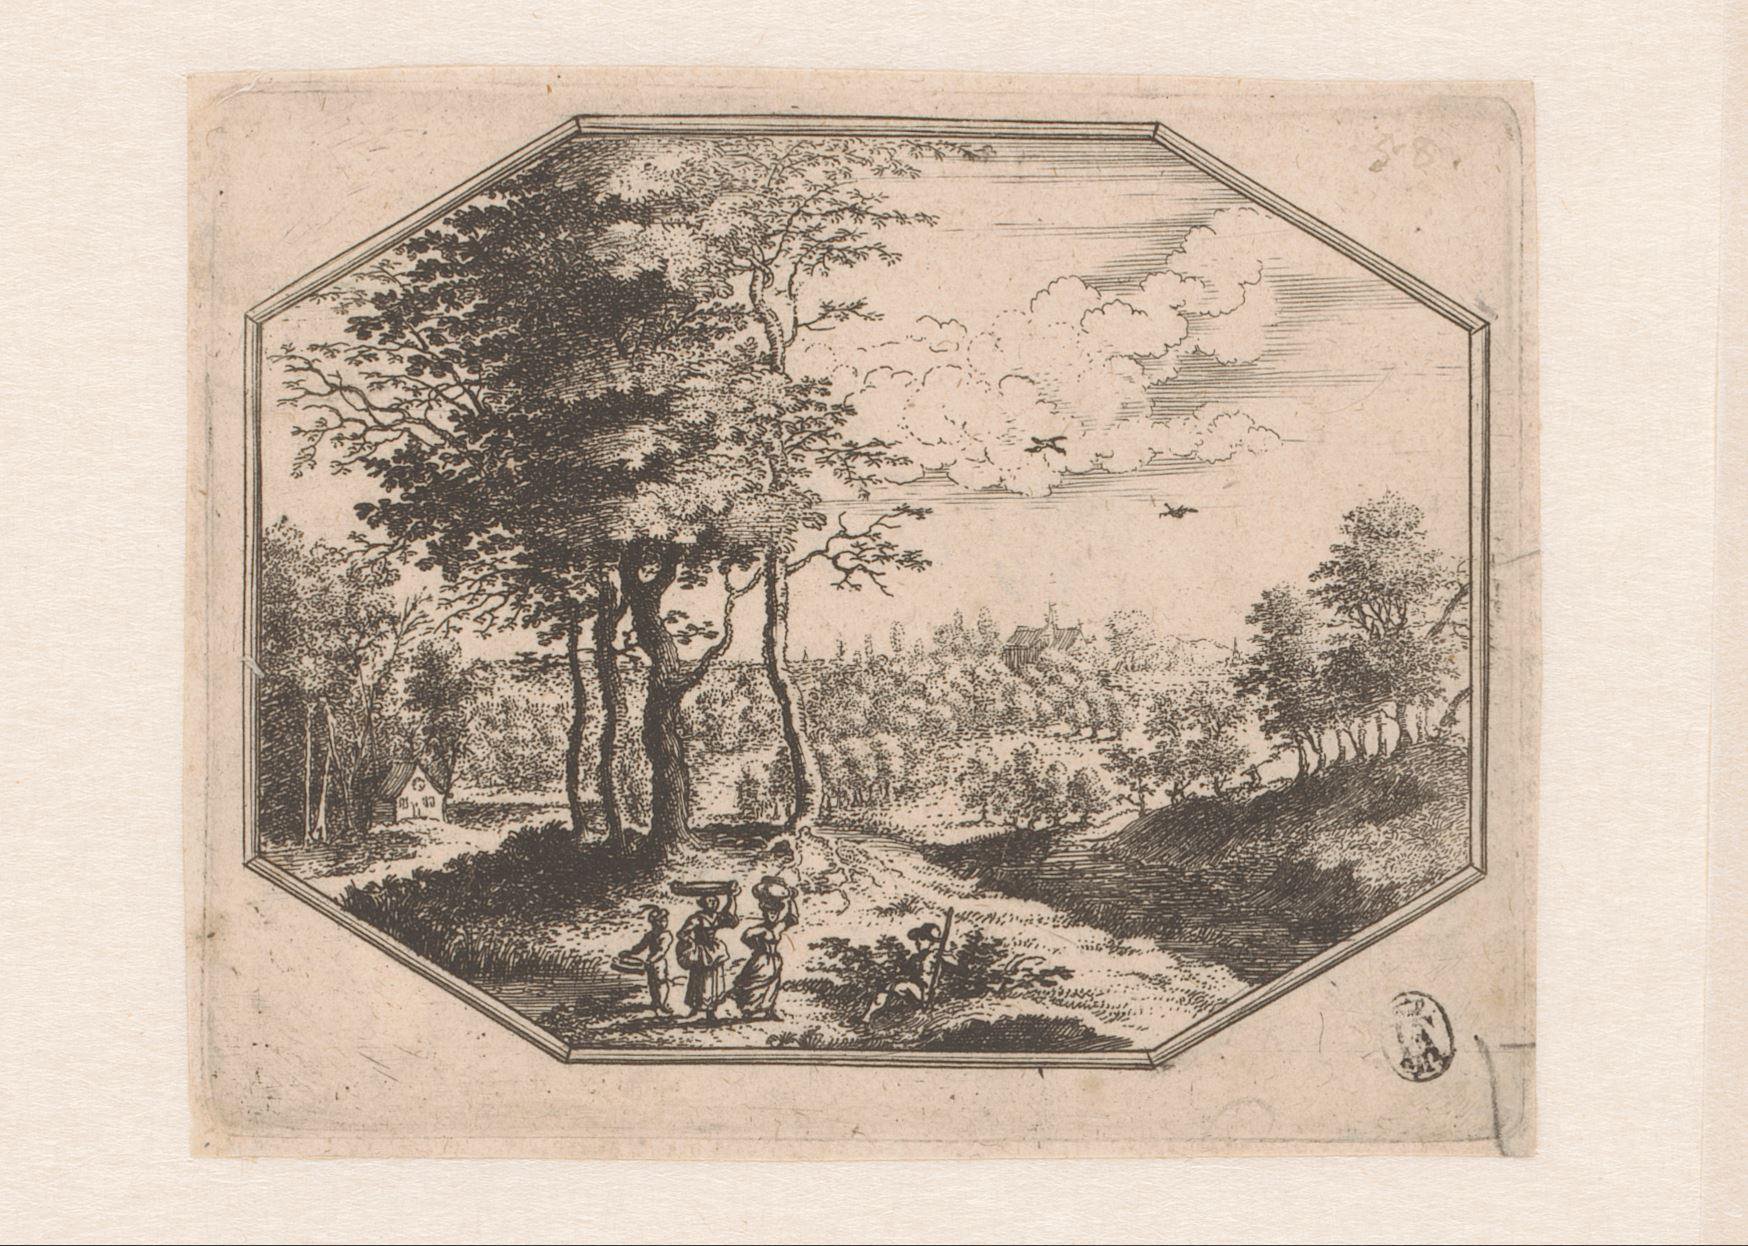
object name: print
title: Landschap met vier figuren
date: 1610-1668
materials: paper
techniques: etching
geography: paris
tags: landscapes (+ landscape with figures, staffage)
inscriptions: collector's mark: Lugt 2228, collector's mark: Lugt 972, number: ‘58.’